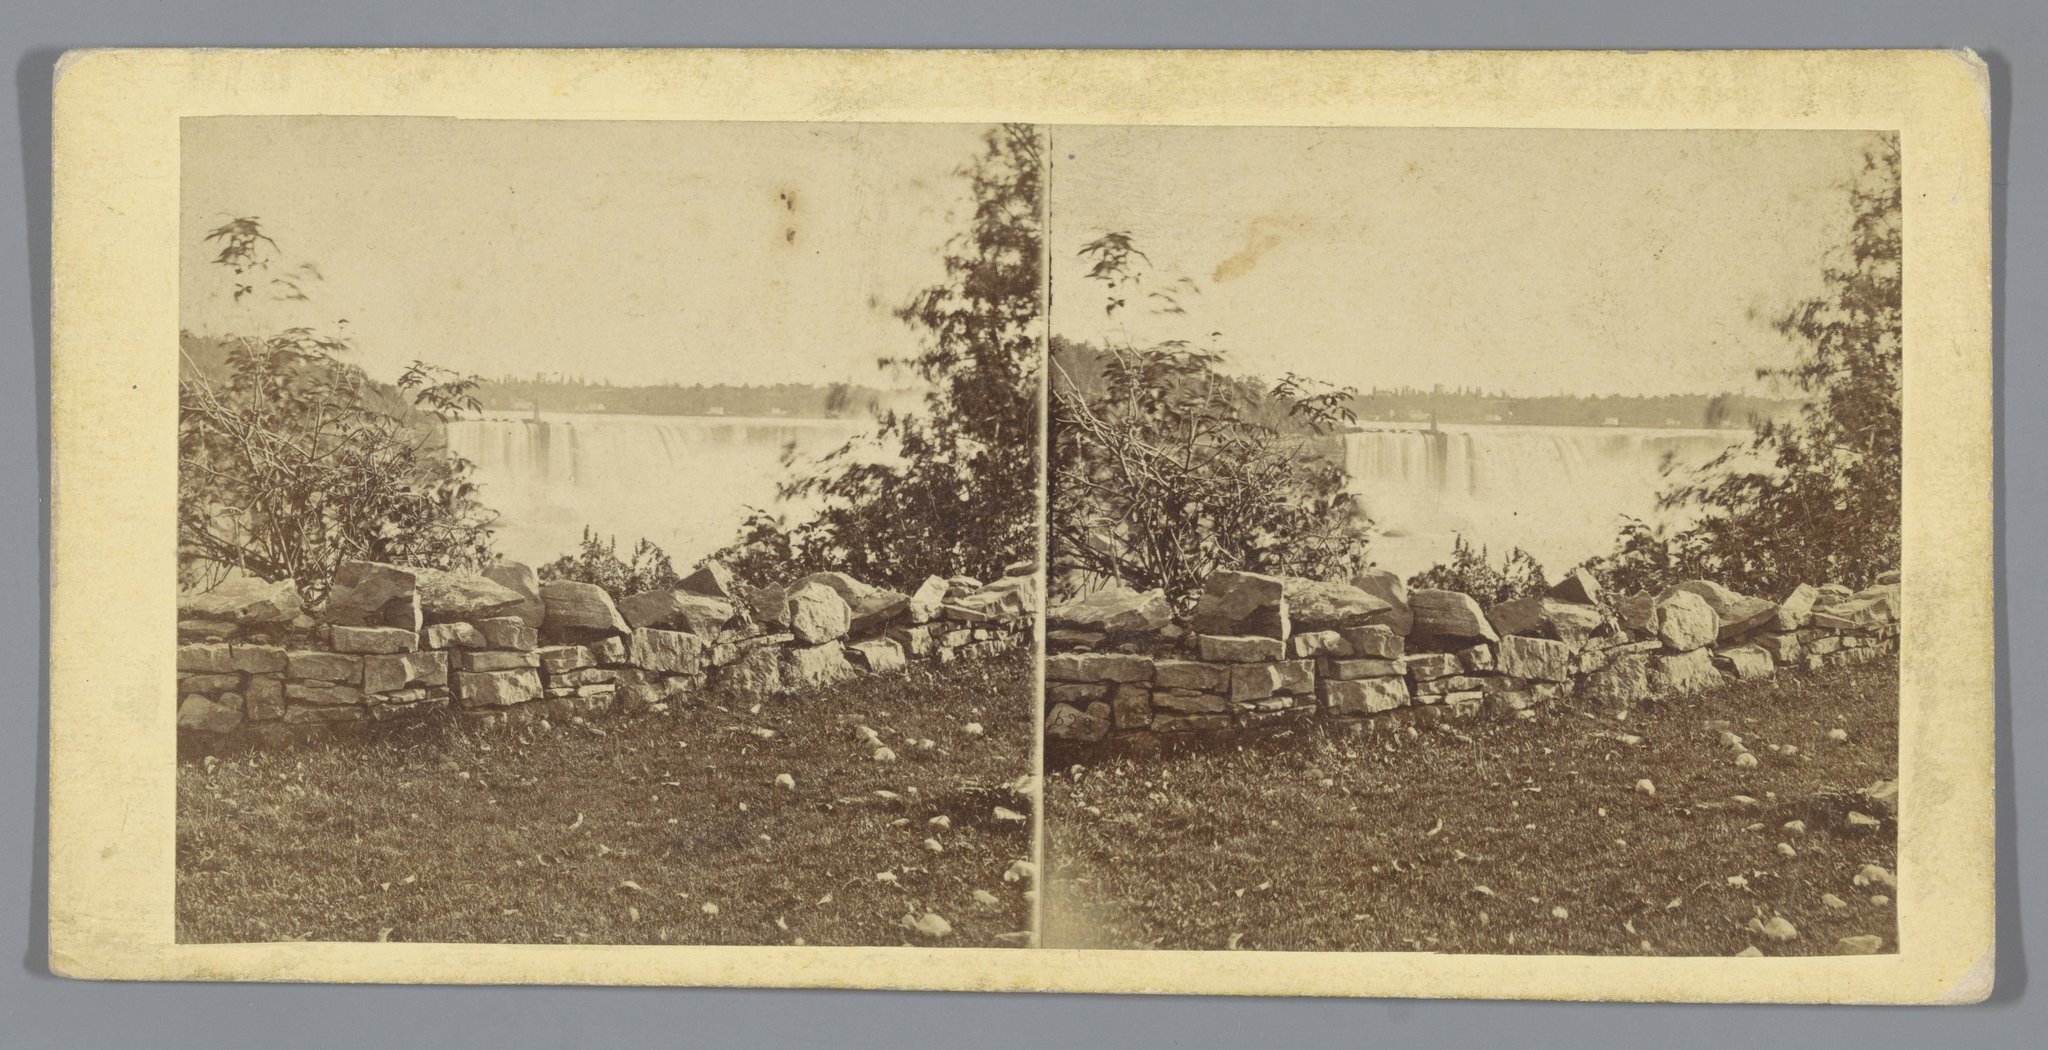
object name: stereograph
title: The Majesty and Beauty of Niagara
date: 1859-1862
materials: cardboard, paper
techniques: albumen print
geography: new york city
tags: waterfall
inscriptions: address: ‘501 Broadway, New-York.’, number: ‘No. 650’